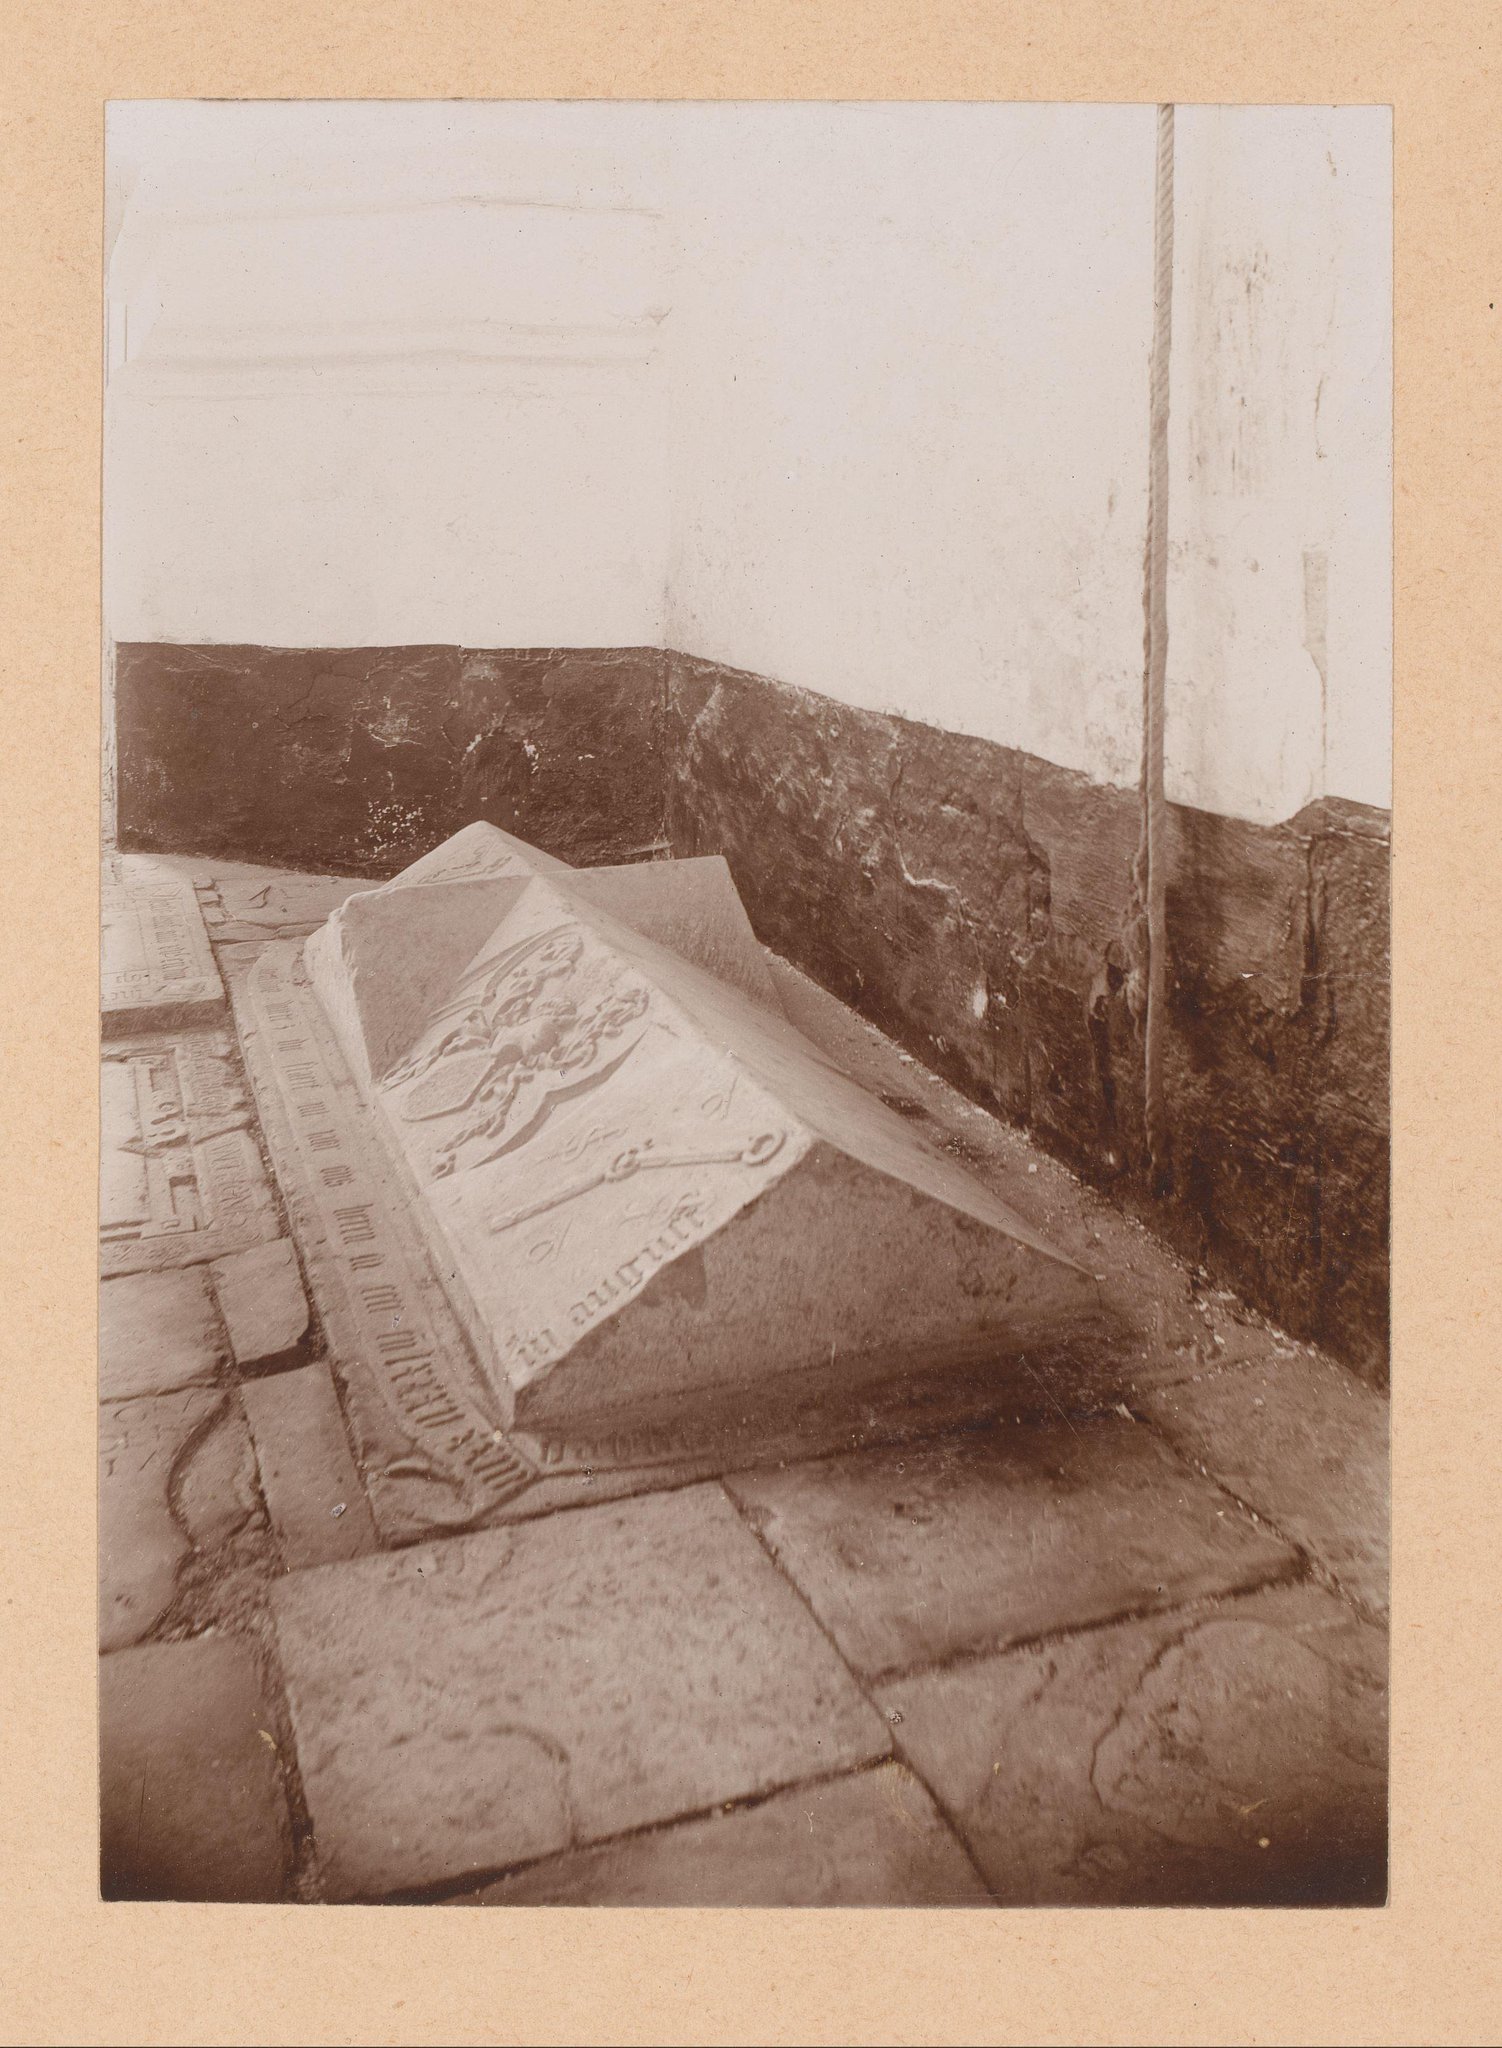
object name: photograph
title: Grafmonument in de Grote of Sint-Catharijnekerk te Brielle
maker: anoniem (monumentenzorg)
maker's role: fotograaf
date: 1908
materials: cardboard, photographic support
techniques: collodion silver print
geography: grote of sint-catharijnekerk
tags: interior of church, grave-building, monumental tomb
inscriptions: annotation: ‘Kerk te Brielle/ April 1908/ Geschenk van Gos de Voogt’, annotation: ‘Brielle/ de N.H. Kerk (H. Catharina) den Briel’, annotation: ‘Kerk te Brielle/ april 1908/ Geschenk van Gos de Voogt’